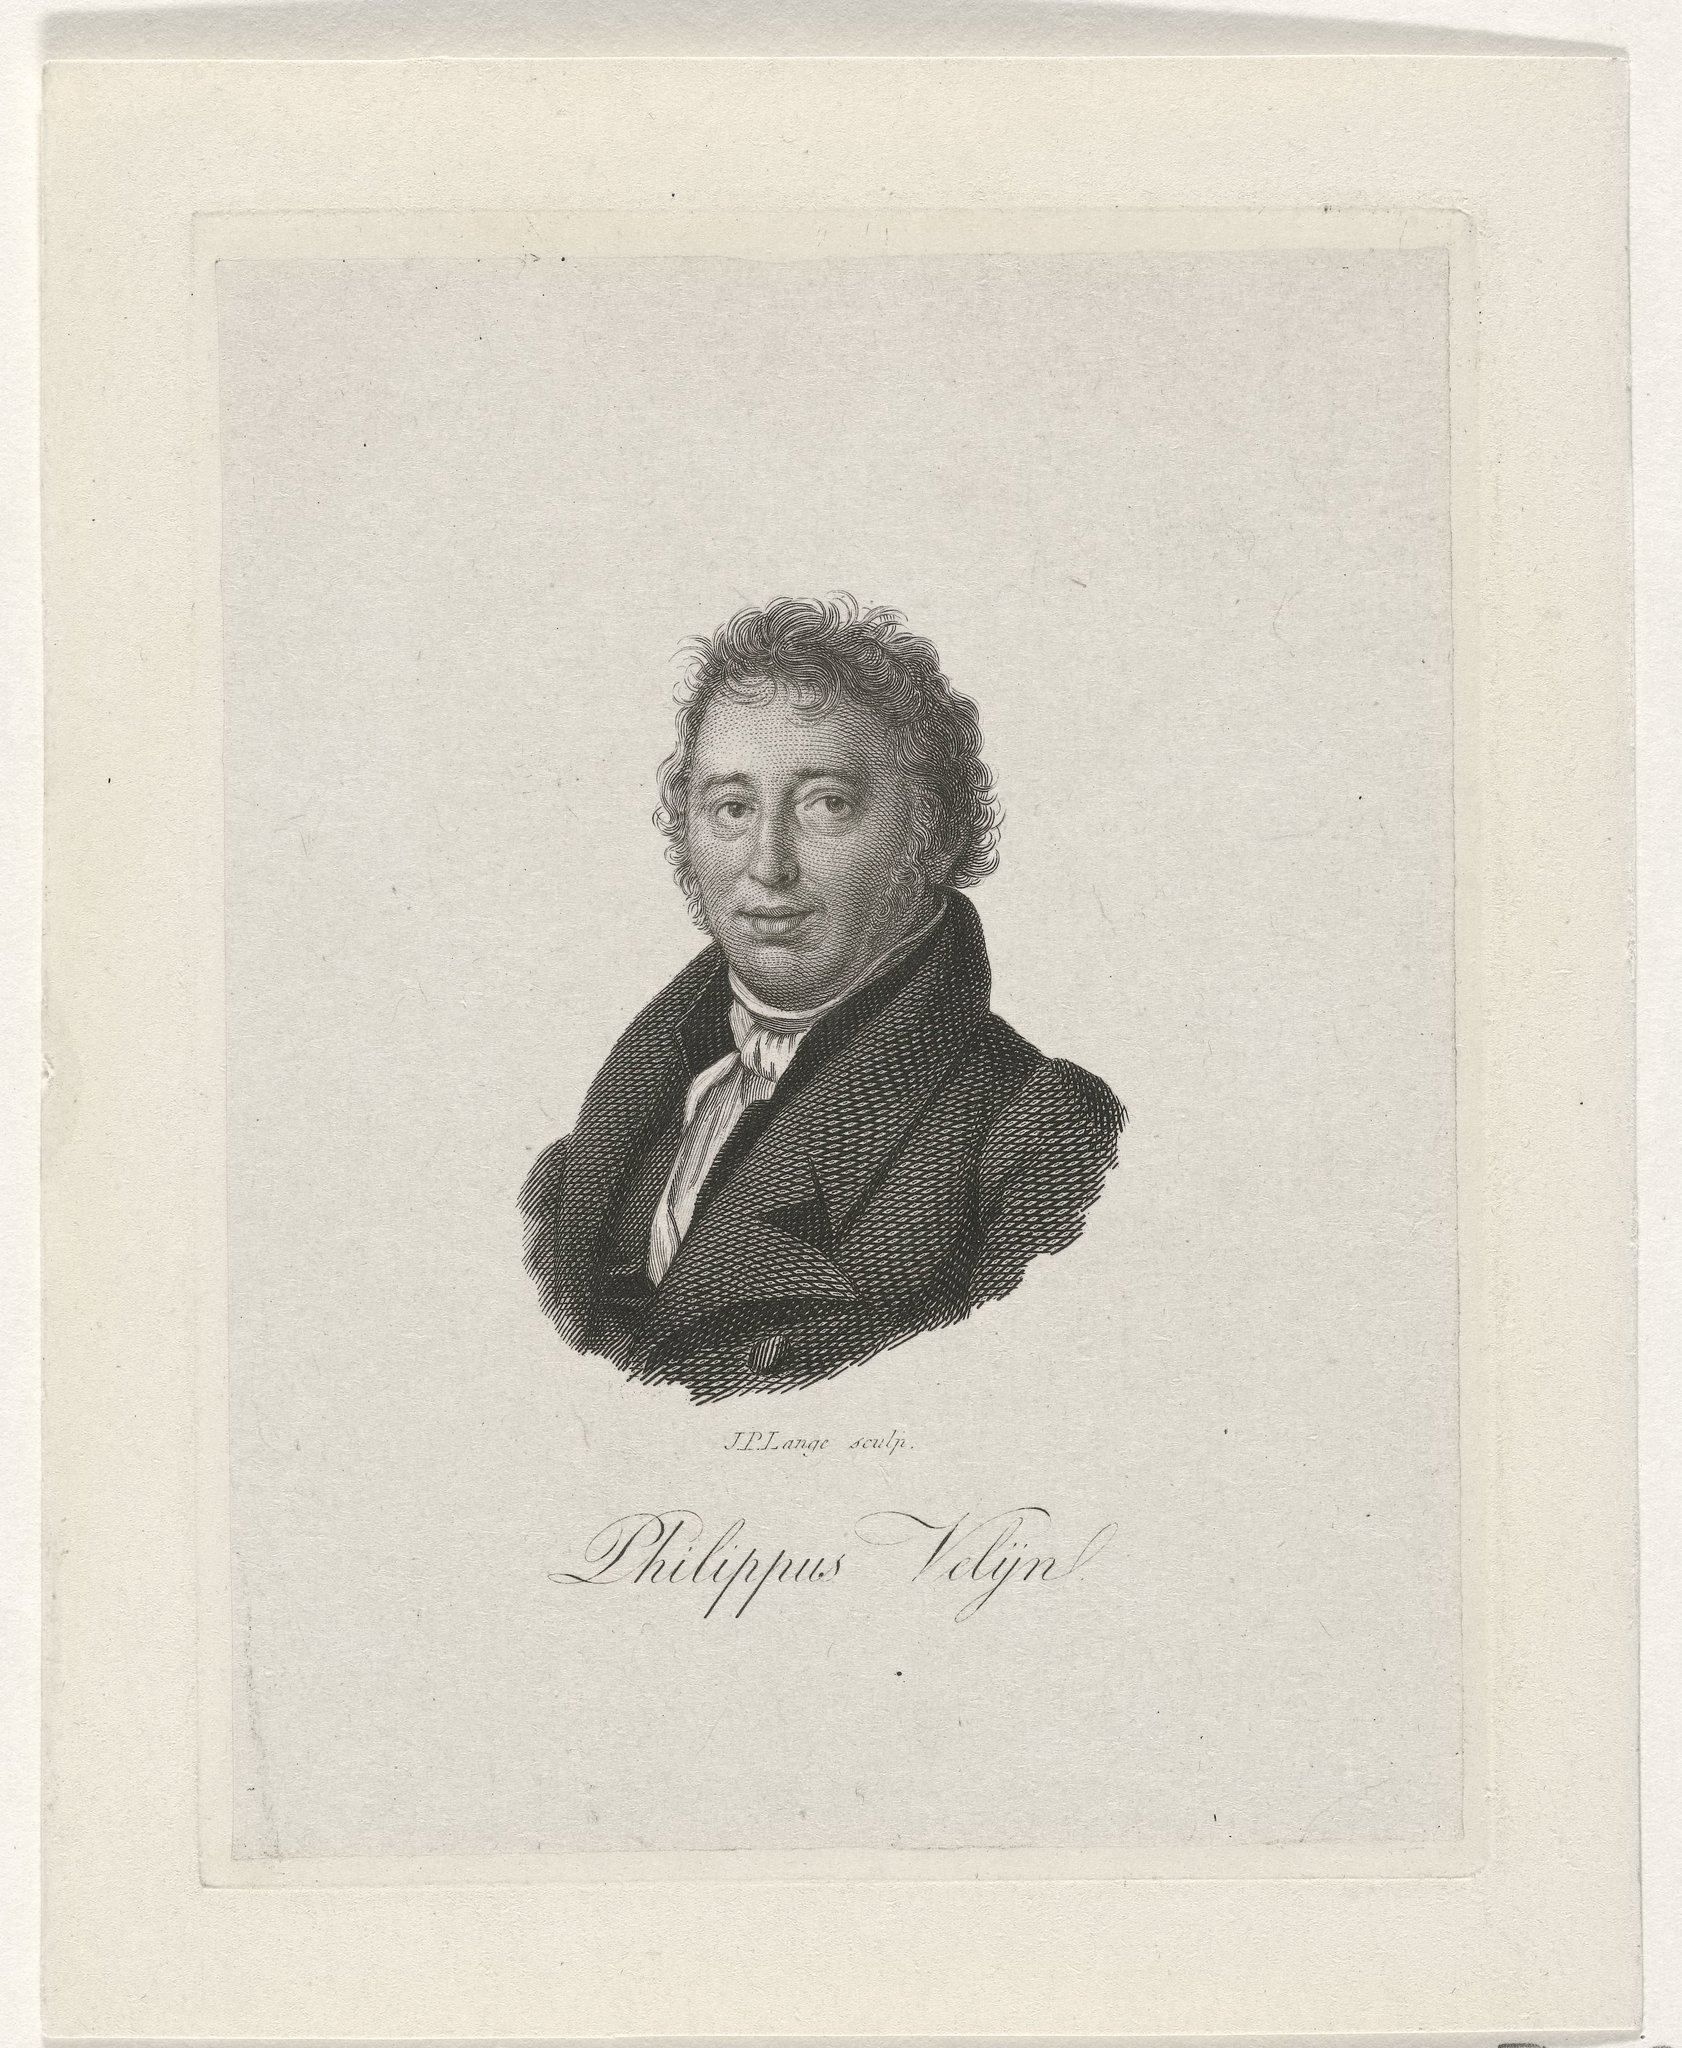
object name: print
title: Portret van Philippus Velijn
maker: johannes philippus lange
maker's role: print maker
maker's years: 1810-1849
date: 1836-1838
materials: paper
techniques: engraving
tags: leiden, print maker, philippus velijn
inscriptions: collector's mark: Lugt 2228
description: Portretbuste naar links van Philippus Velijn, graveur te Amsterdam.